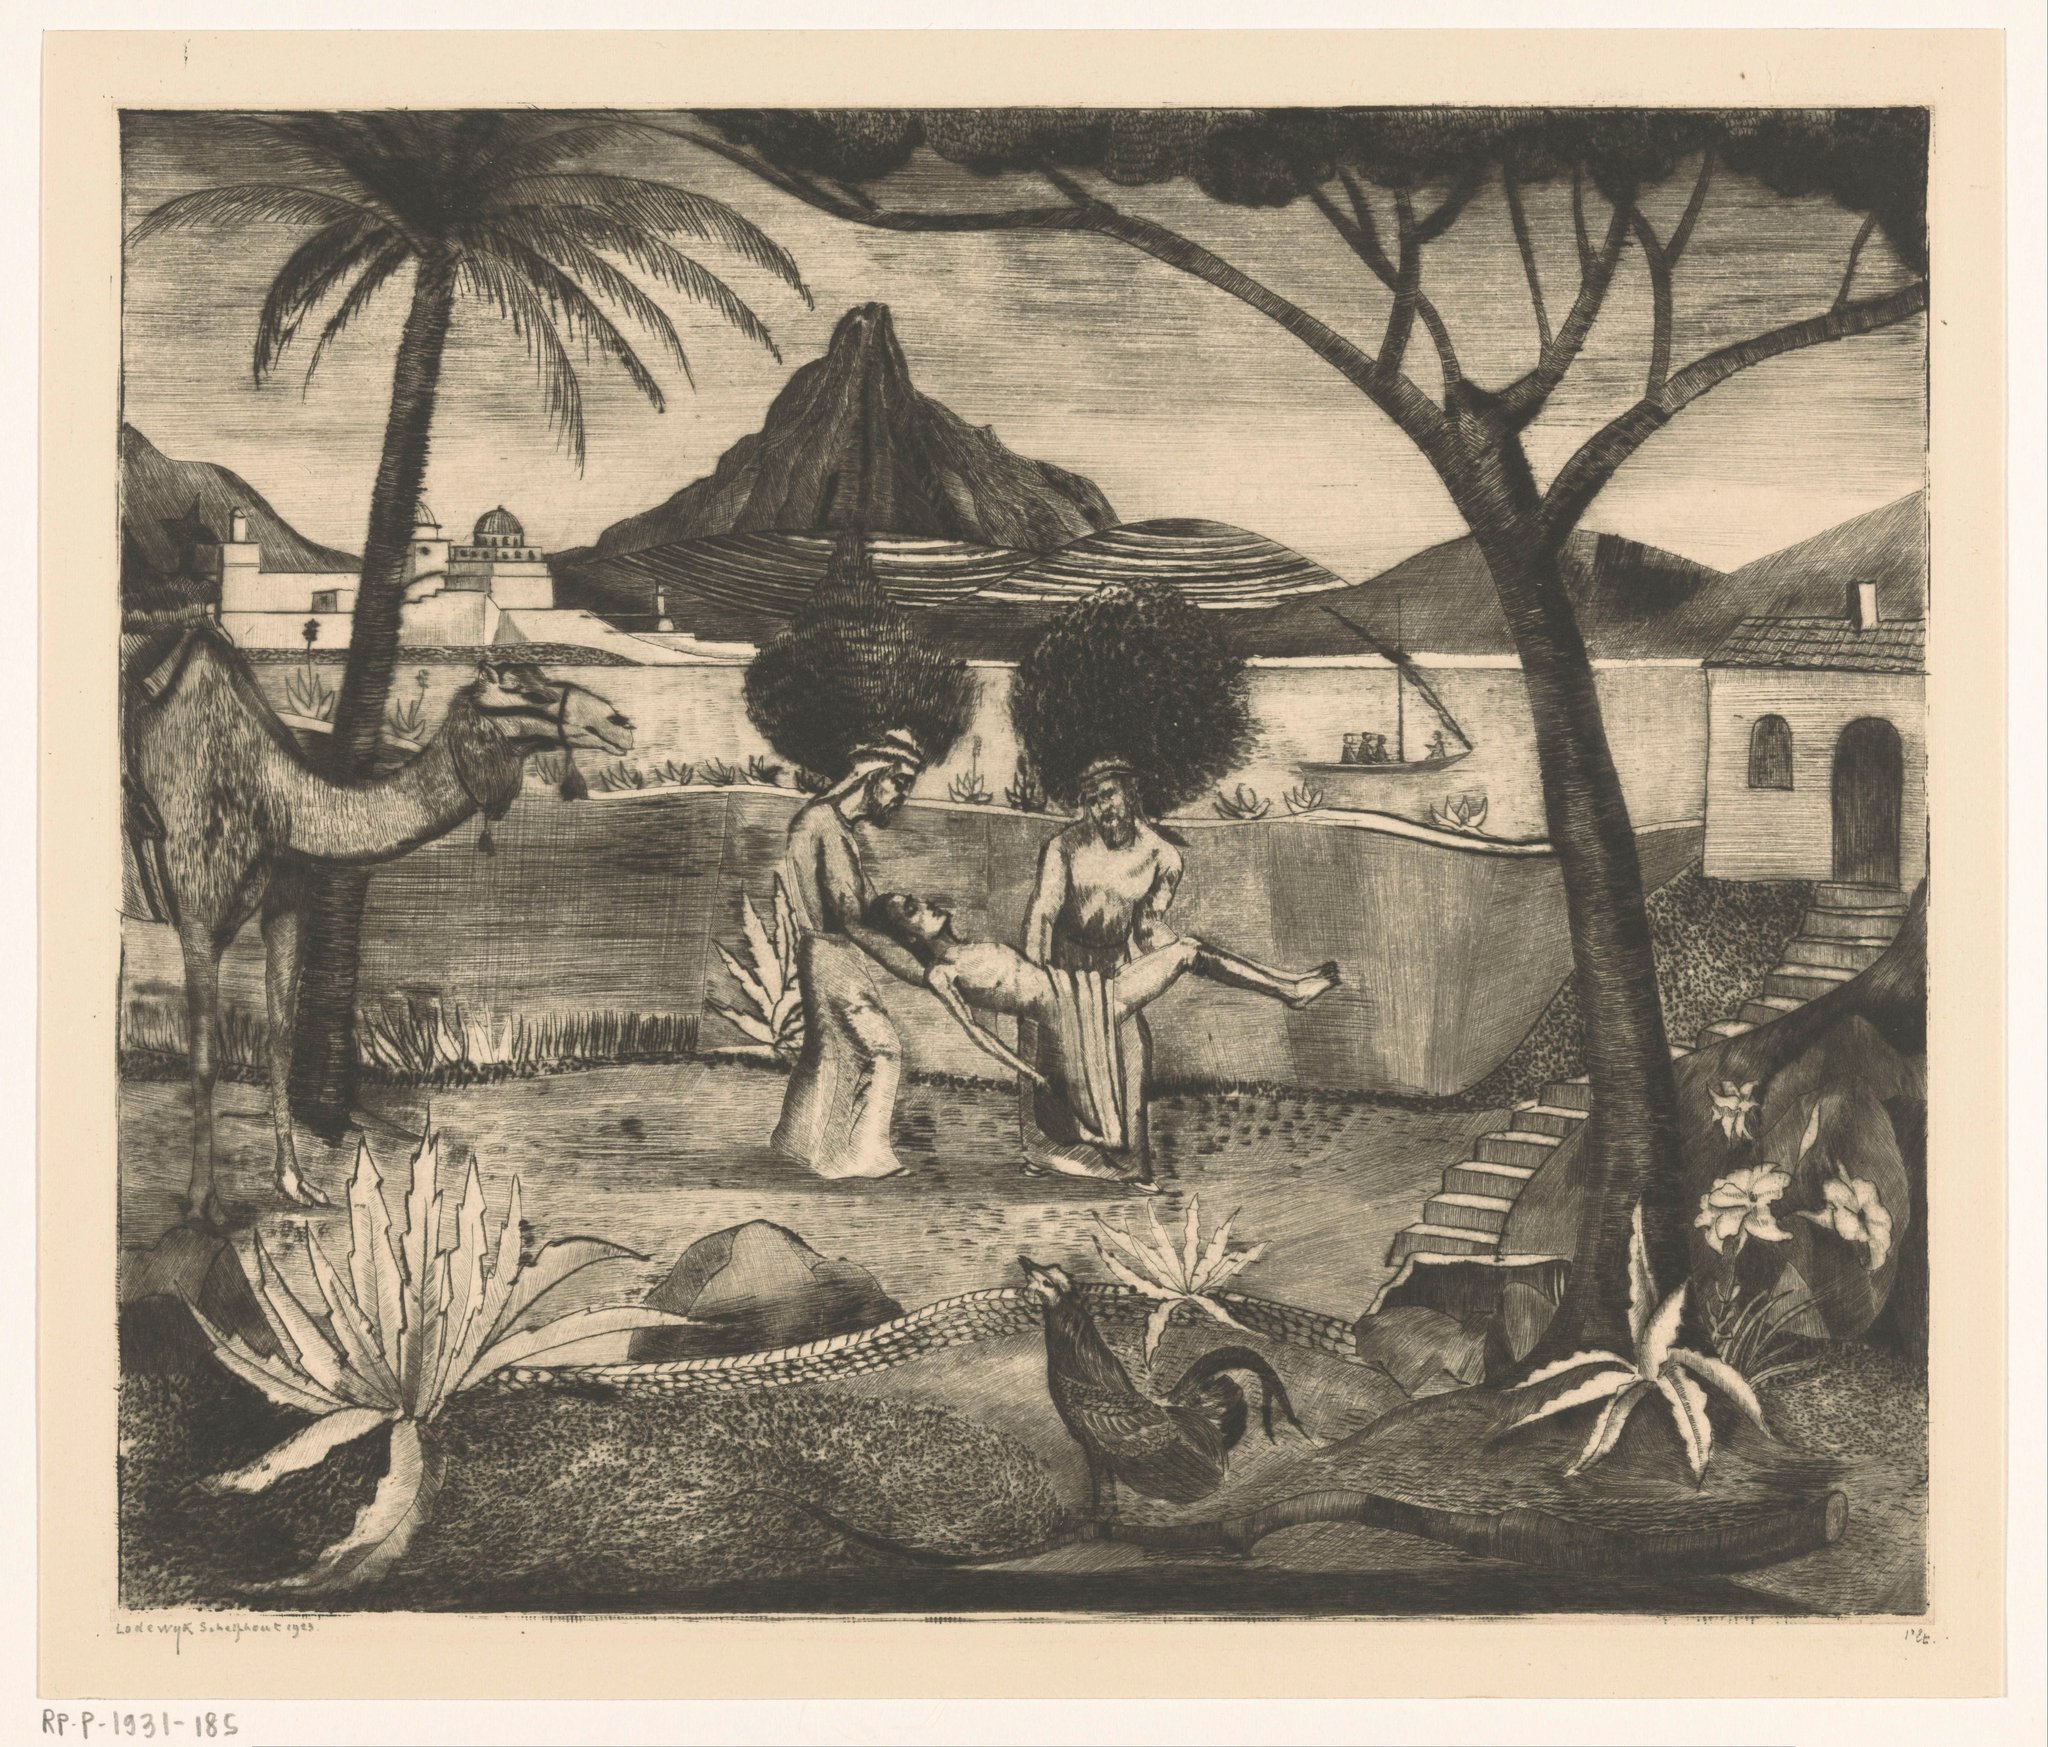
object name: print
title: Twee mannen die in een tuin een man dragen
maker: lodewijk schelfhout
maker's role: draughtsman, print maker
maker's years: 1881-1943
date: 1923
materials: paper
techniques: drypoint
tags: hoofed animals: camel, carrying a person, the good samaritan (luke 10:30-37), garden, fowl (cock, hen, chicken, etc.)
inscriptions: collector's mark: Lugt 2228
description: De twee mannen, mogelijk is één van hen de barmhartige Samaritaan, dragen de man richting een gebouw. In de tuin bevinden zich een kameel, een haan en verschillende soorten planten. Op de achtergrond bergen en een gebouw met koepels aan een baai.